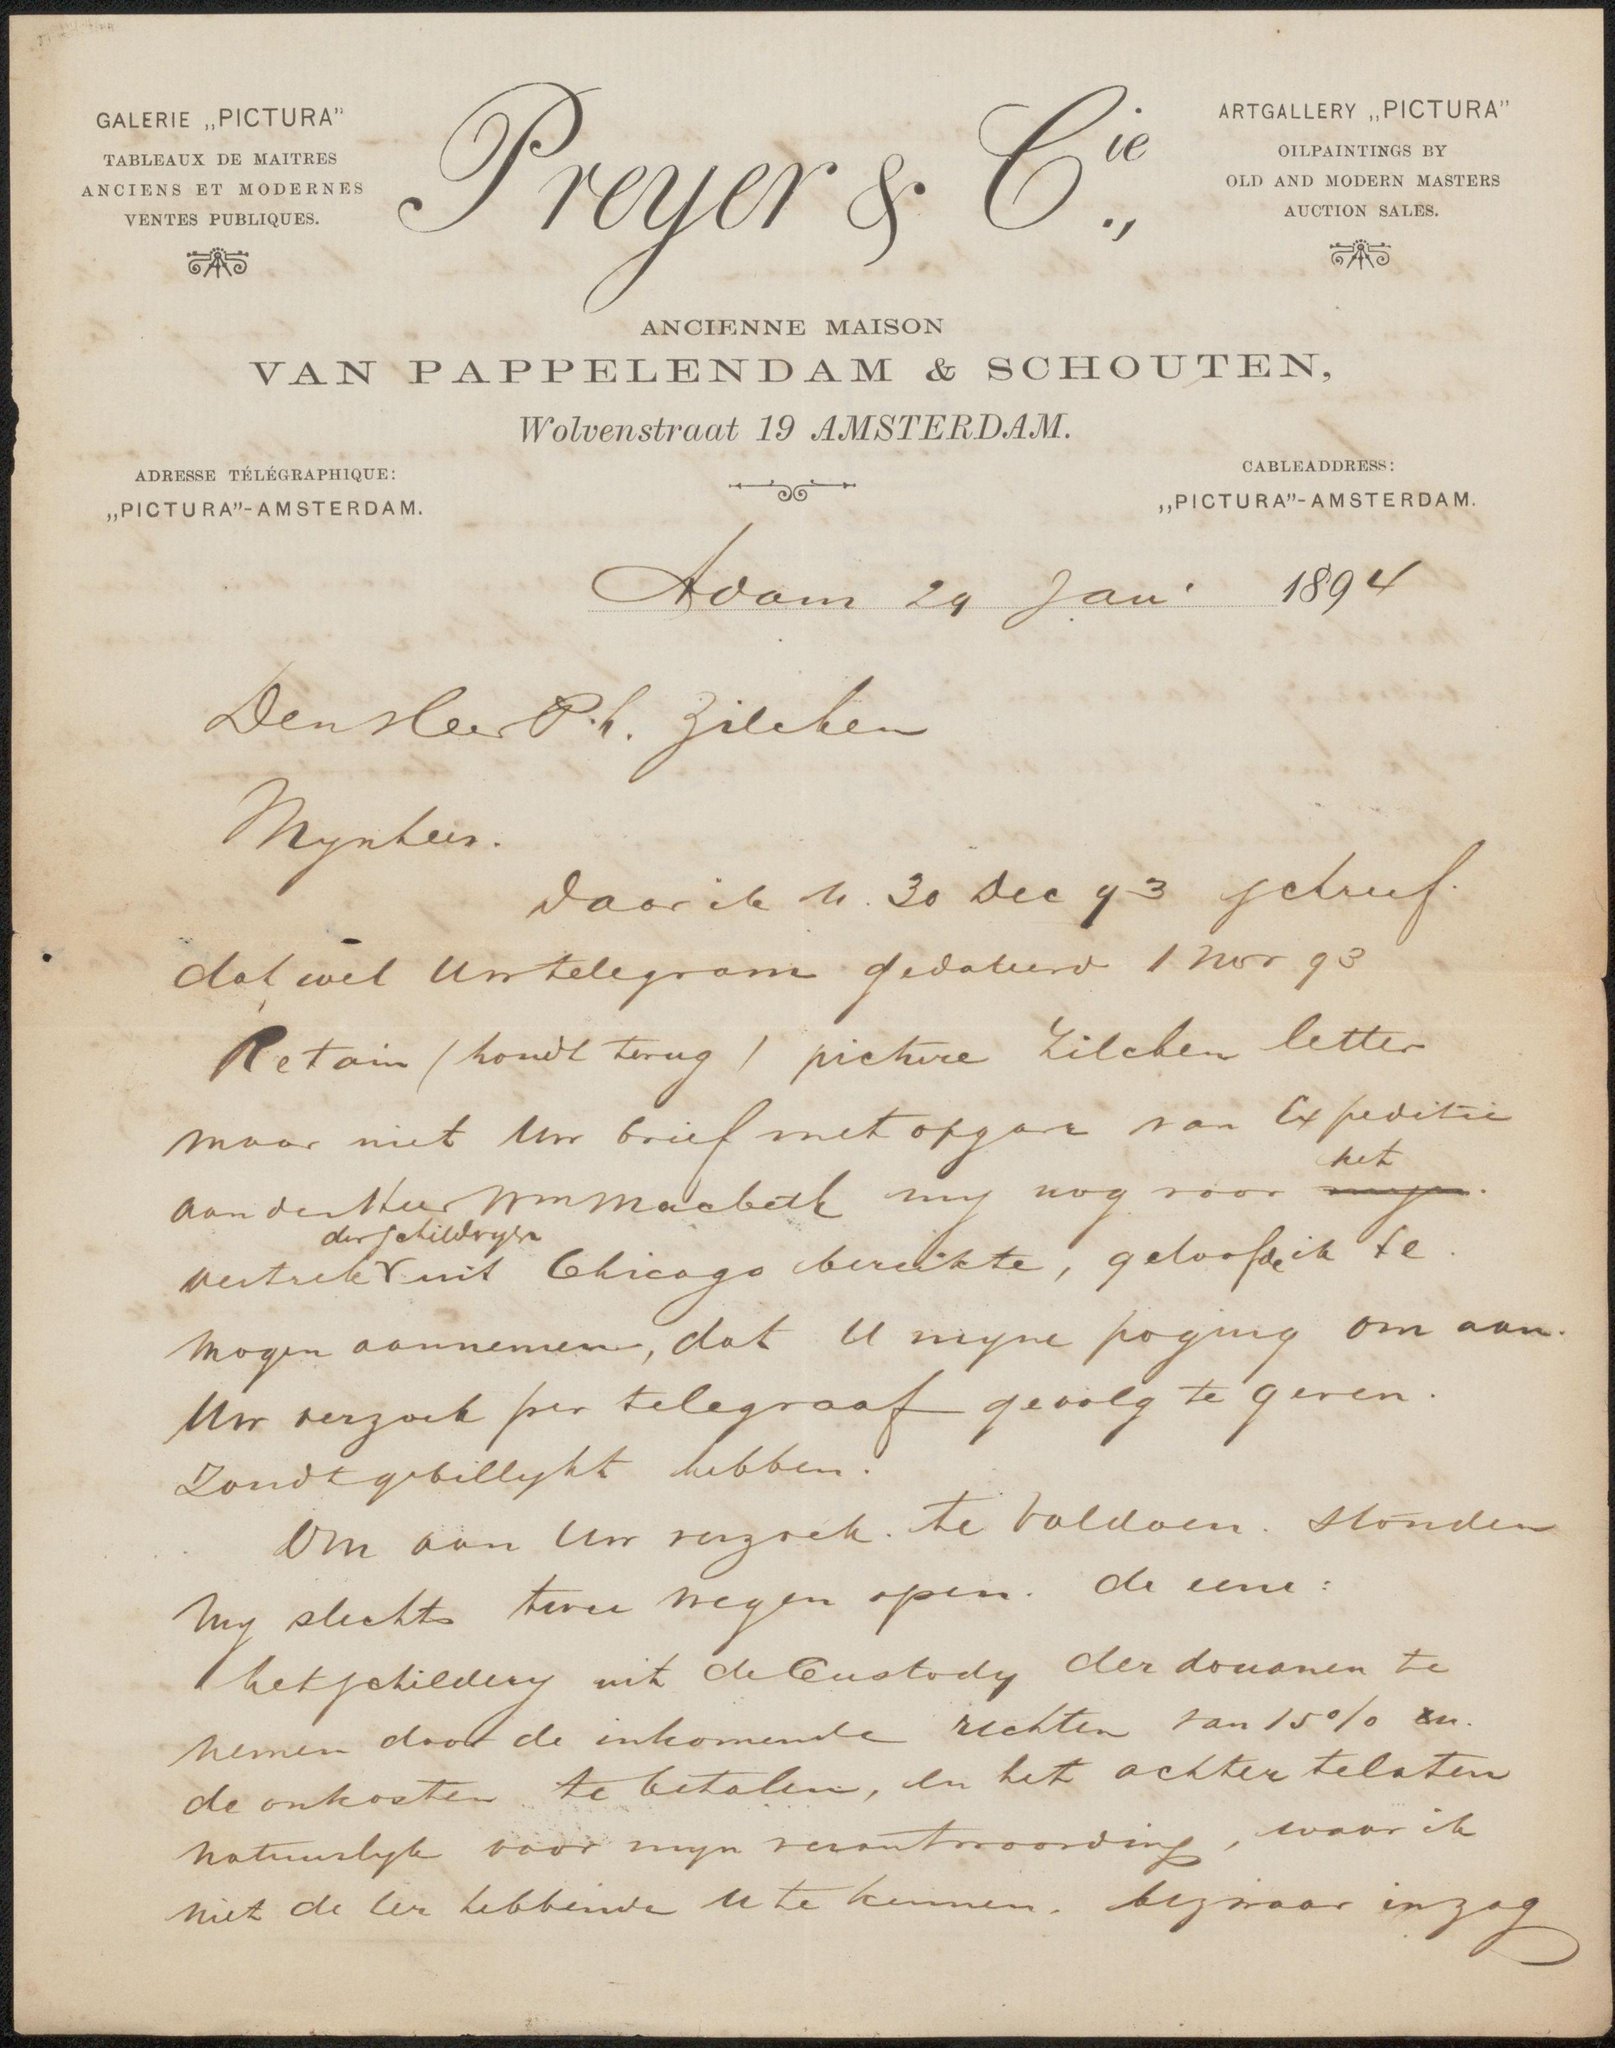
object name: letter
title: Brief aan Philip Zilcken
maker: abraham preyer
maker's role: auctioneer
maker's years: 1862-1927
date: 1894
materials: ink, paper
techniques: pen, printing, writing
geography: amsterdam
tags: william macbeth, the hague, painter, draughtsman, philip zilcken, art trade, art shop, painting (including book-illumination, miniature-painting), exhibition ~ art, money, new york (city)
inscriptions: watermark